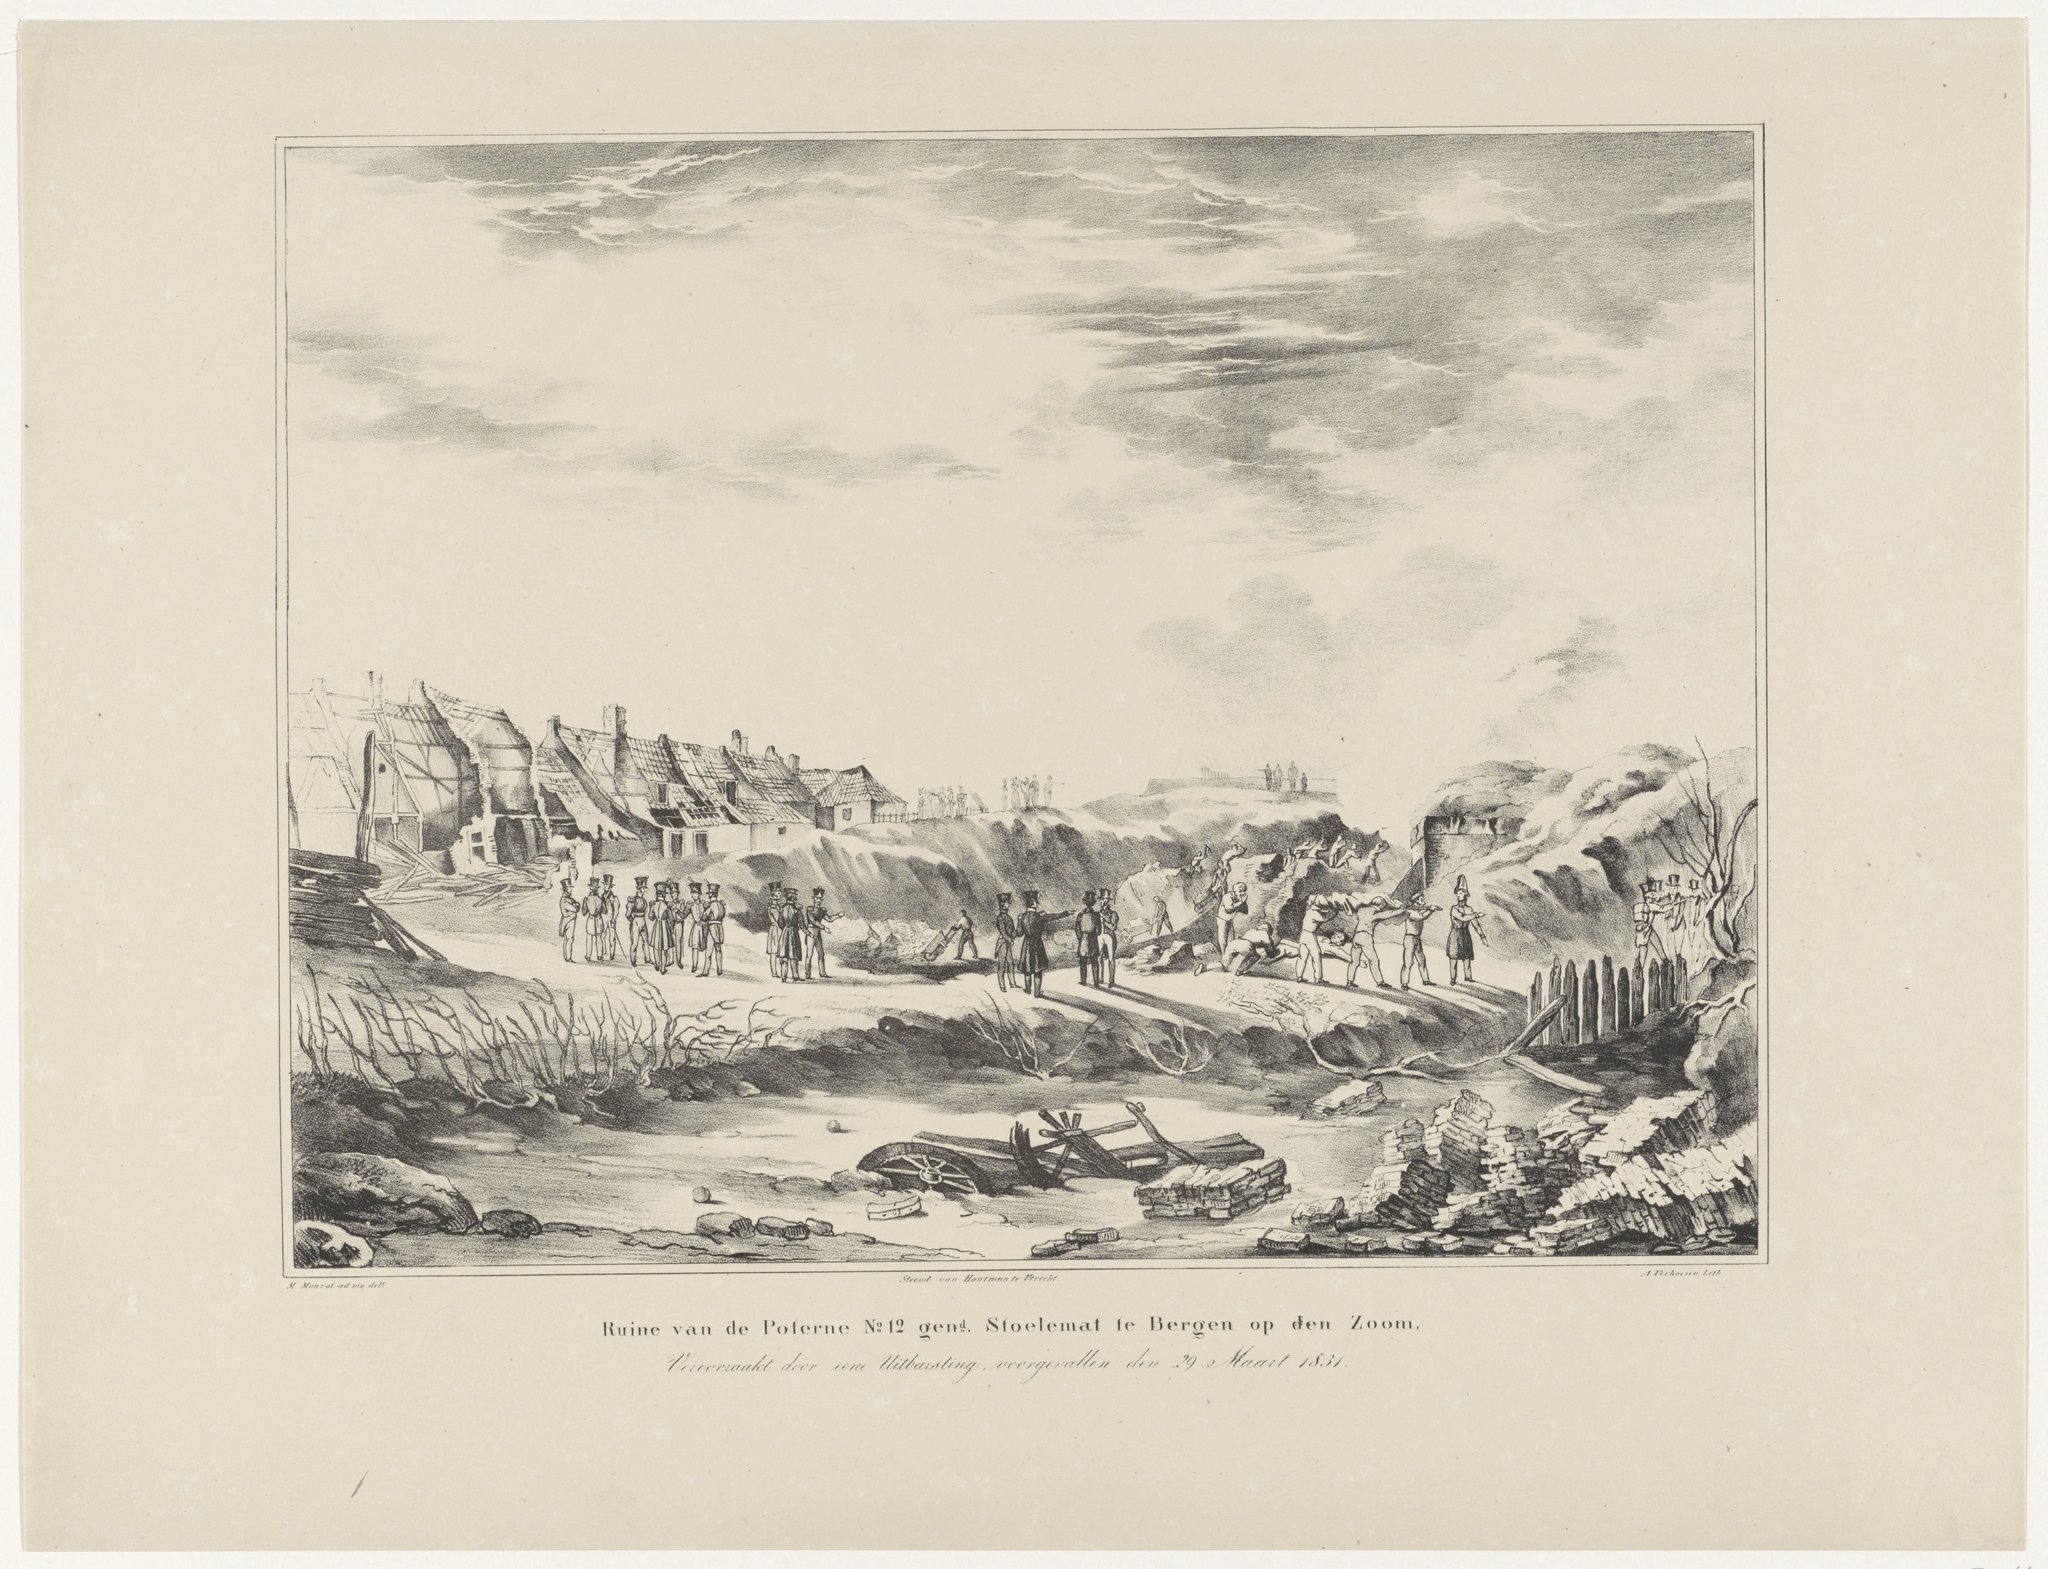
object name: print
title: Ruine van de Poterne No. 12 gen.d Stoelemat te Bergen op den Zoom, veroorzaakt door eene Uitbarsting voorgevallen den 29 Maart 1831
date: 1831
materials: paper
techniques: lithograph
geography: utrecht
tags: laboratory, research room, gunpowder disaster, bergen op zoom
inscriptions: collector's mark: Lugt 2233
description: Wegdragen van de slachtoffers en het opruimen van de puinhopen na de ontploffing in de kruitmagazijn van laboratorium Stoelemat te Bergen op Zoom, 29 maart 1831.